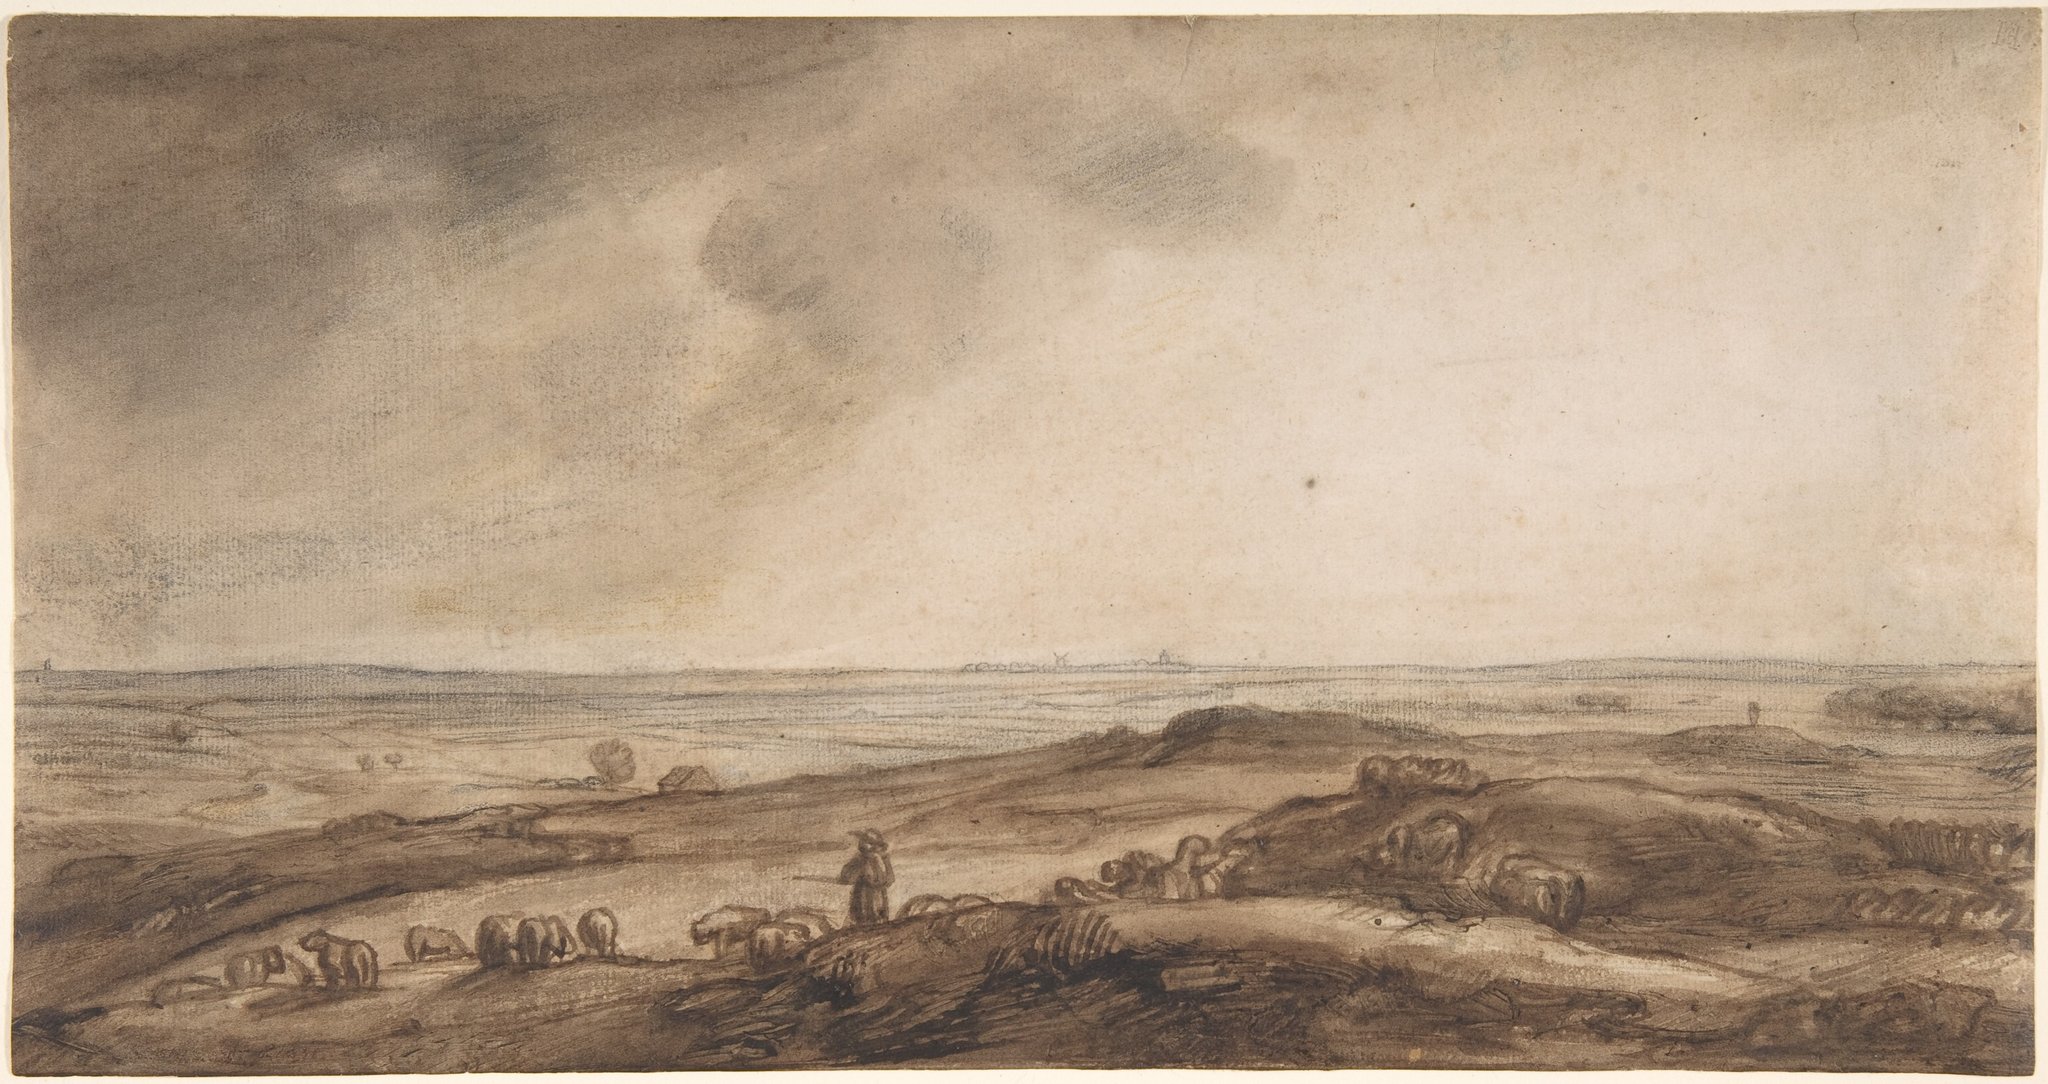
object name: drawing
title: A Panoramic Landscape with a Herdsman and His Flock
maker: jan ruischer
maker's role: artist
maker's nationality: dutch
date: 1601-1700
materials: chalk, ink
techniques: brush, pen, wash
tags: animals,men,landscapes